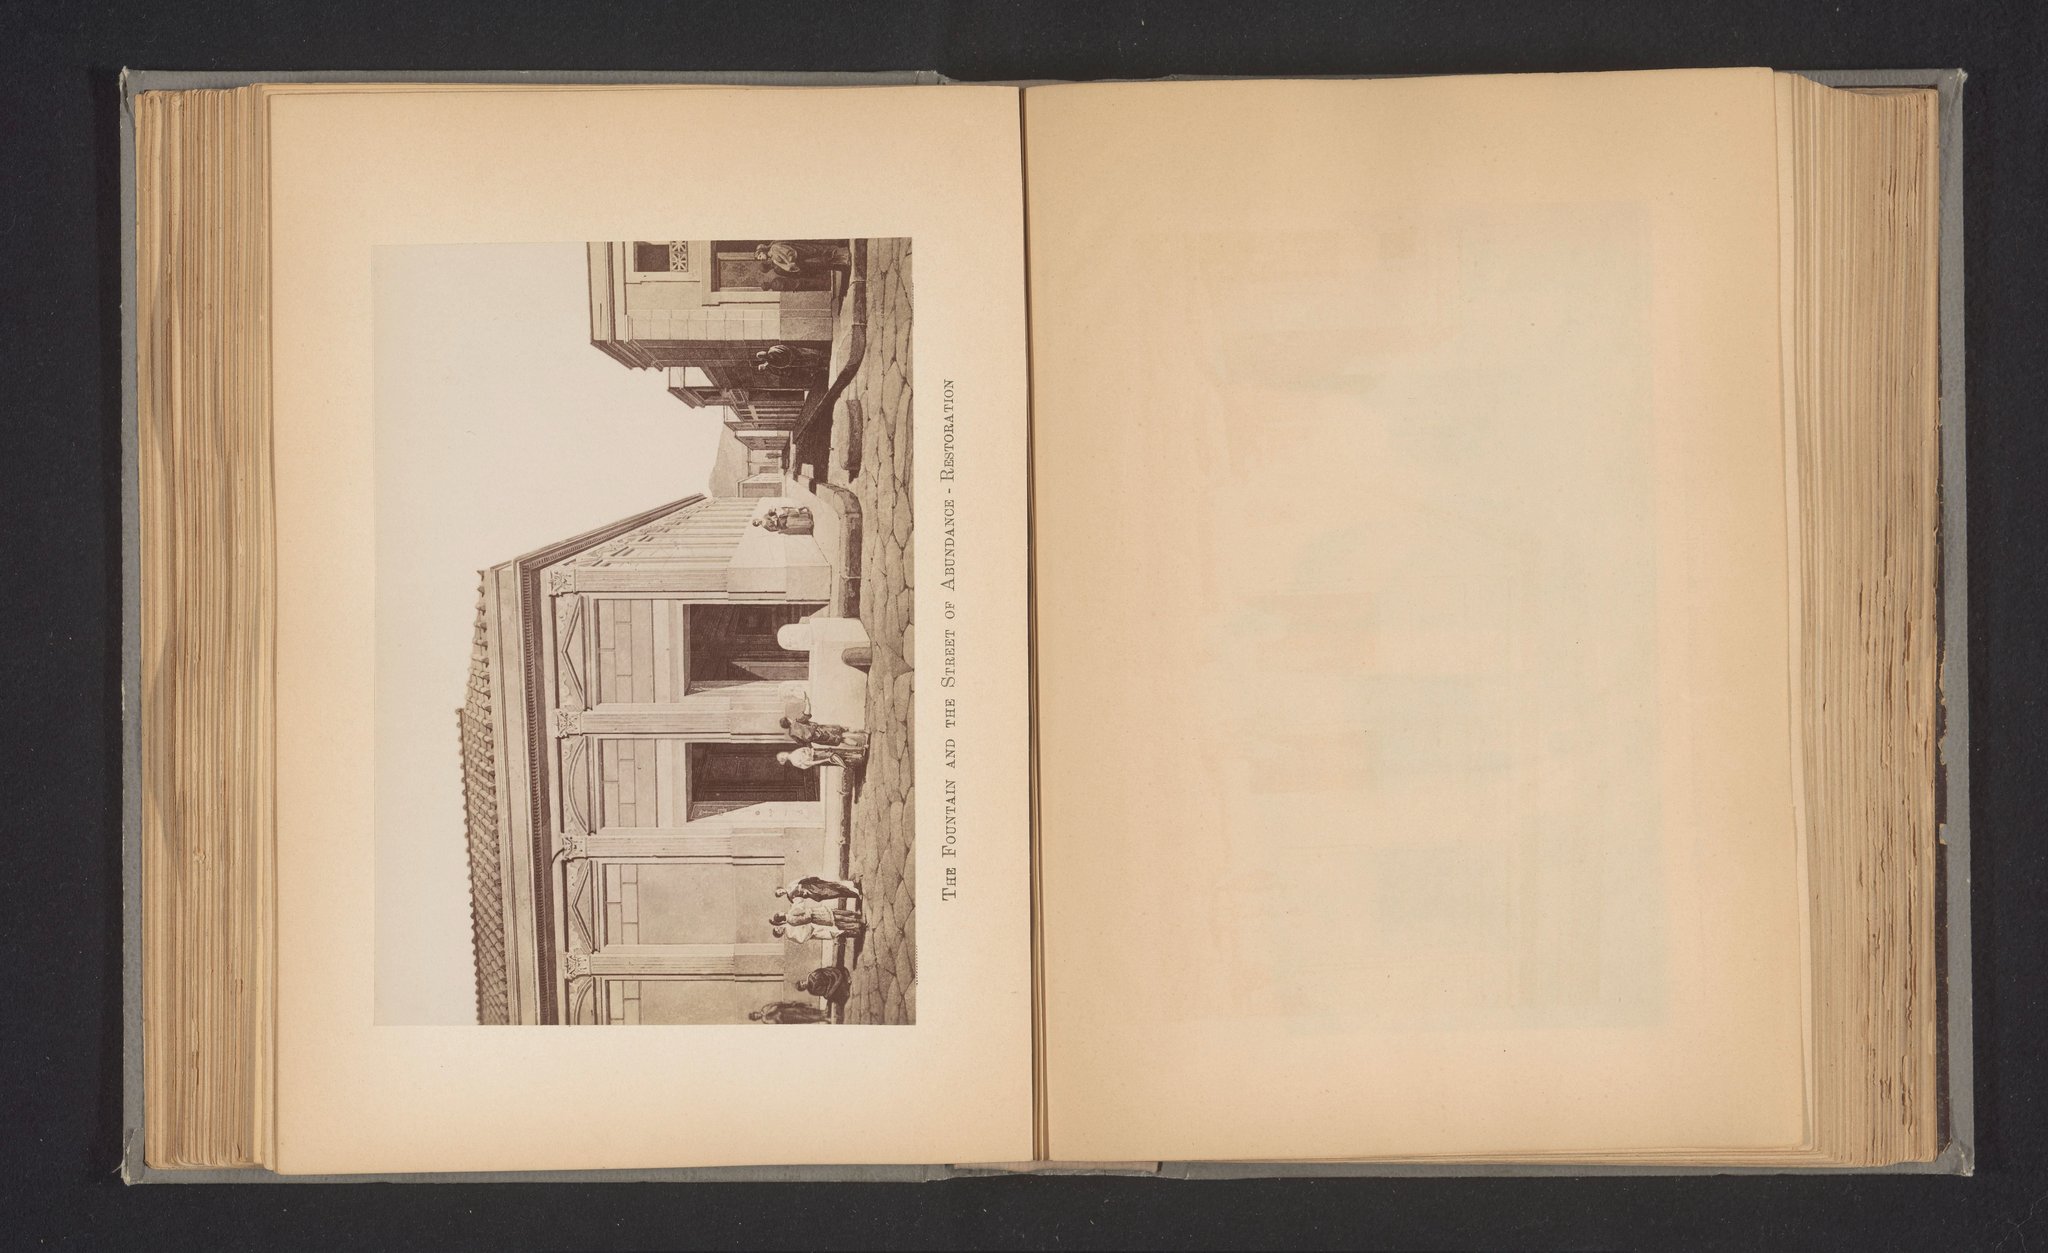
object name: reproduction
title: Fotoreproductie van een gezicht op de Fontein en Via dell'Abbondanza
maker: Anonymous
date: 1890-1895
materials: photographic support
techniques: albumen print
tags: street